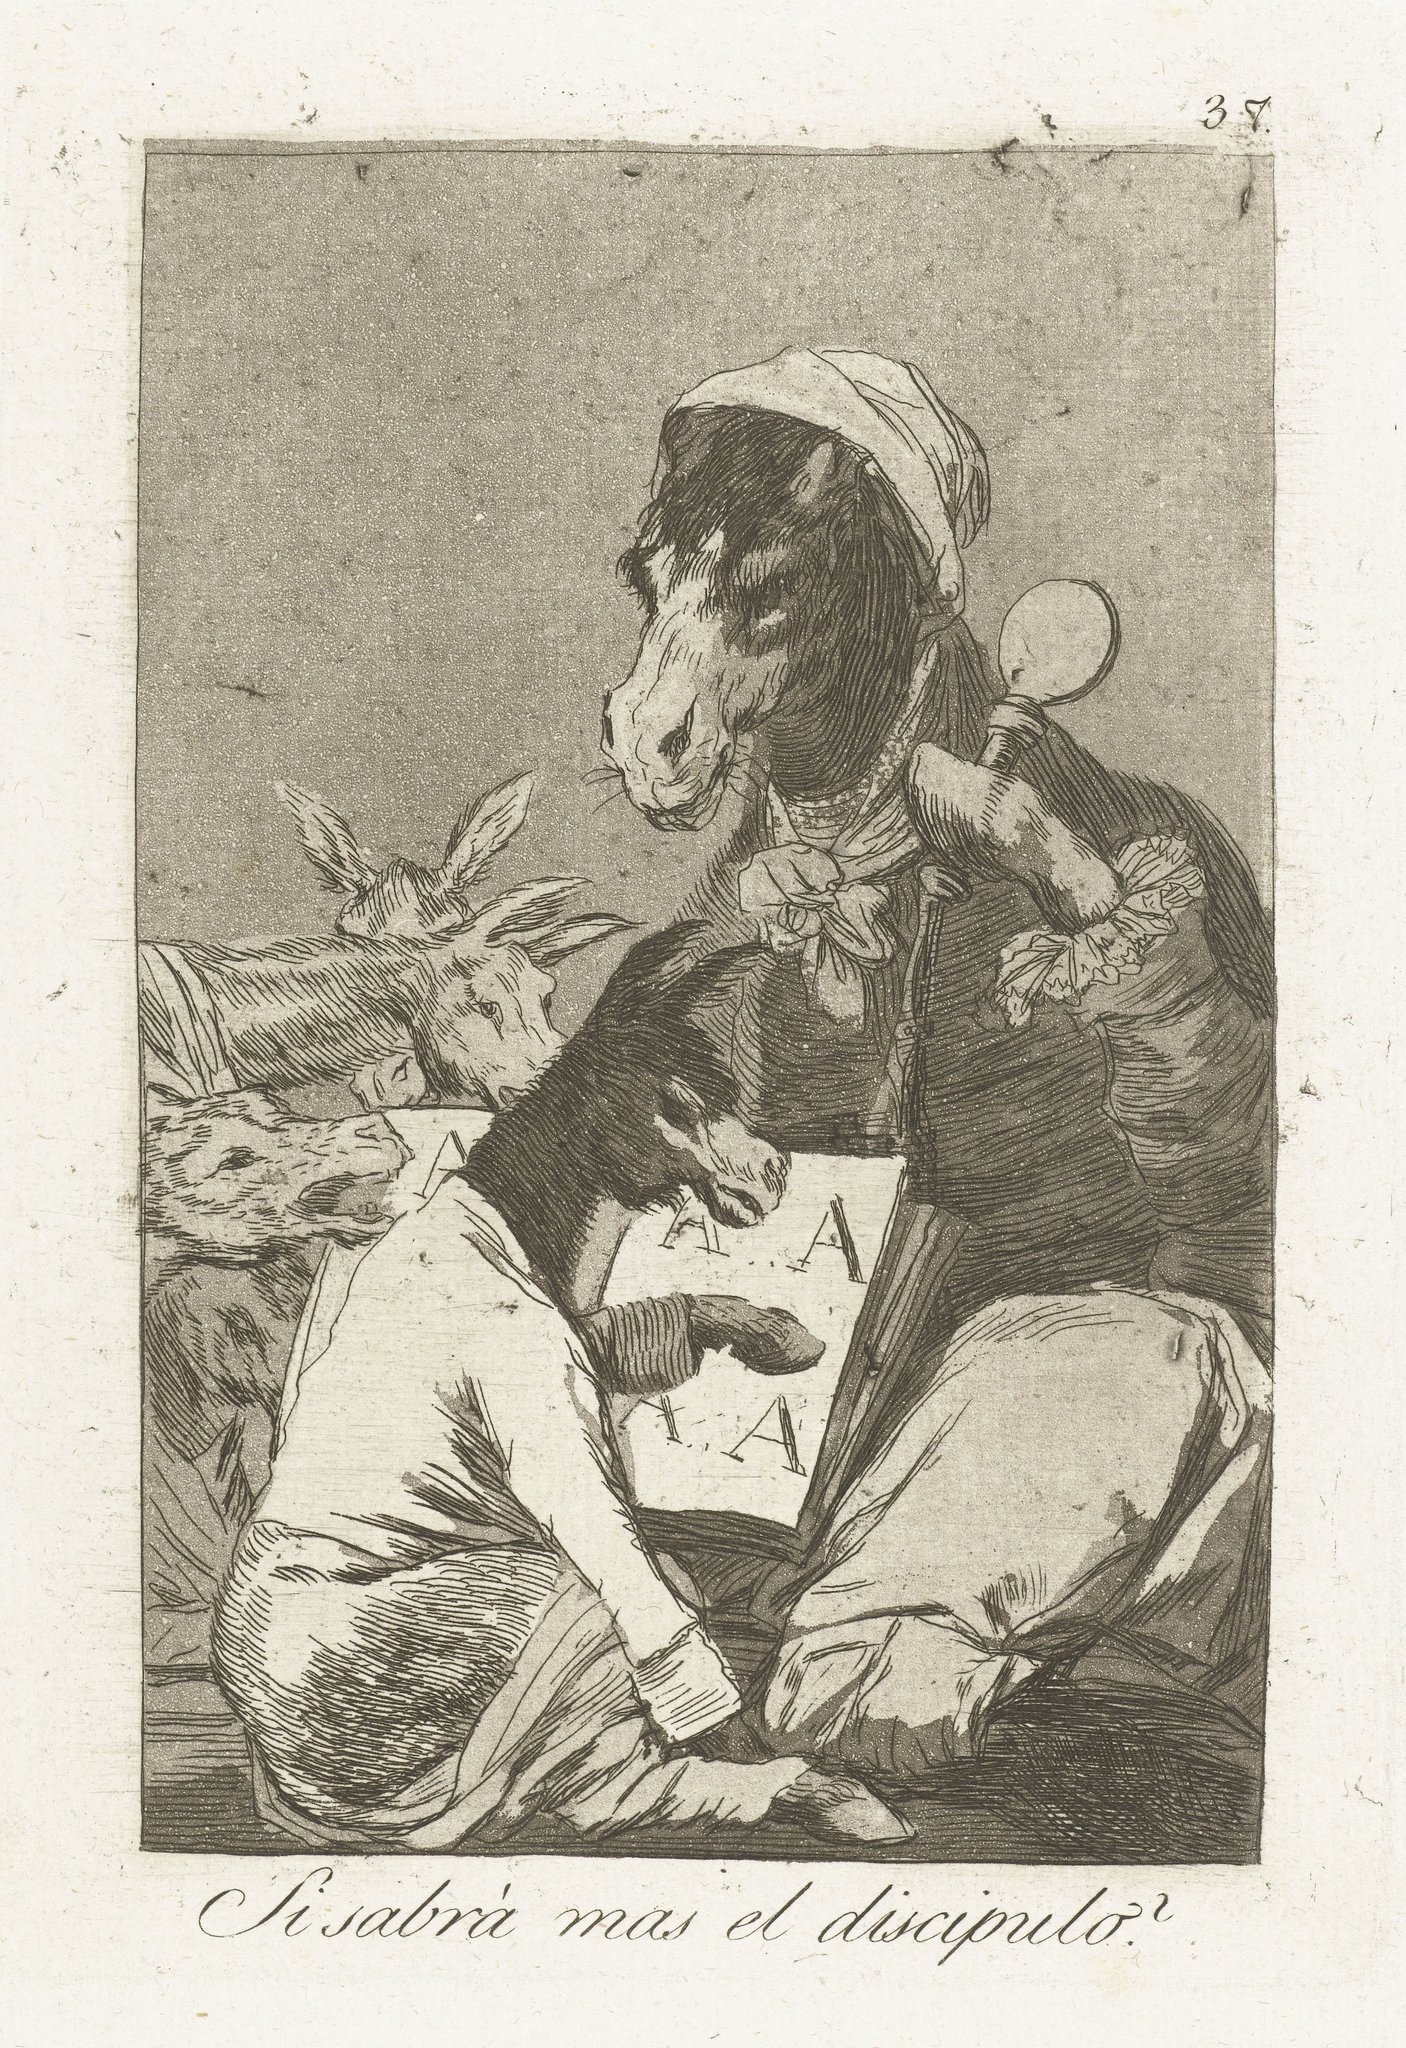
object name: print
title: Los Caprichos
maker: francisco de goya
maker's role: draughtsman, painter, print maker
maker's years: 1746-1828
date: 1797-1799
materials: paper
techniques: aquatint, etching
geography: spain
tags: ass, donkey, animals acting as human beings, scholastic education, tuition (+ lesson, lecture)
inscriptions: collector's mark: Lugt 2228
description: Een ezel, aangekleed als onderwijzer, met vier ezels als leerlingen. Zevenendertigste prent uit de serie Los Caprichos.